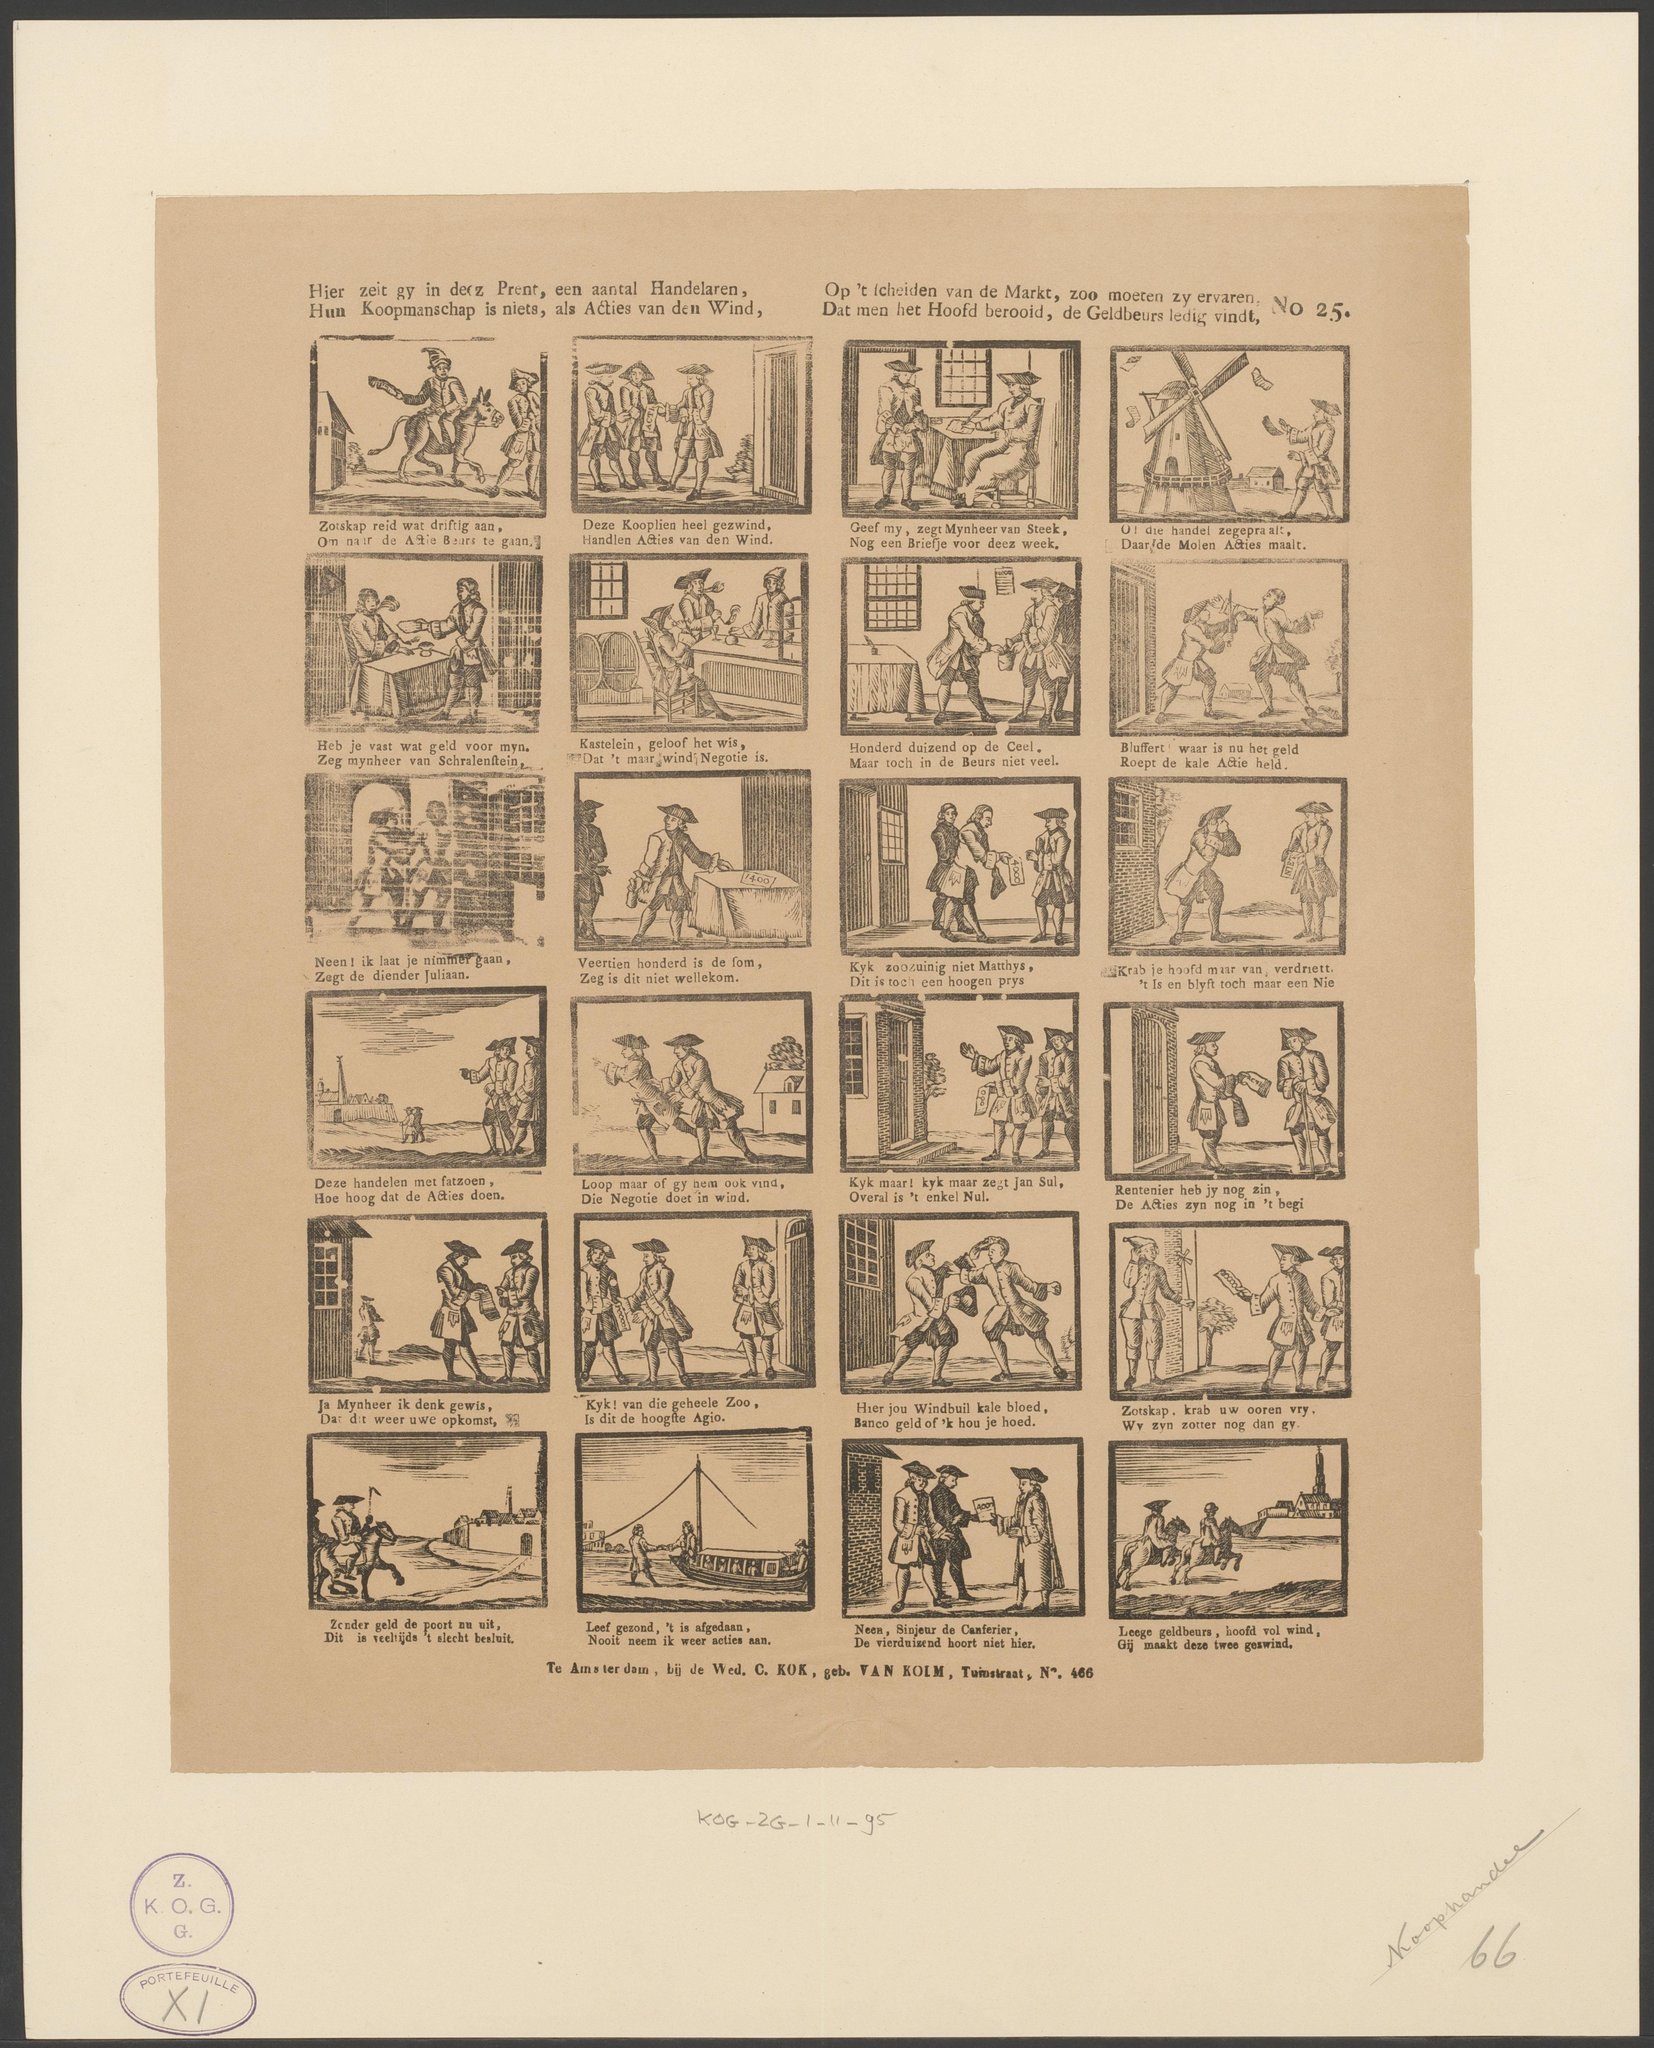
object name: popular print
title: Spotprent op de Actiehandel, 1720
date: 1720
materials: paper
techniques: letterpress printing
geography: amsterdam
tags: negative results and undesired aspects of trading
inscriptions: collector's mark: Lugt 1641, stamp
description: Spotprent op de Windhandel of Actiehandel van 1720. Volksprent met 24 voorstellingen. Onder elke voorstelling een tweeregelig vers. Bovenaan genummerd: No. 25. Onderwerpsrubrieken binnen de Atlas Zeden en Gewoonten: Handel, nijverheid en verkeer, Koophandel, Veilingen, Makelaardij en Verzekeringswezen, Herinneringen op het gebied van den Koophandel.